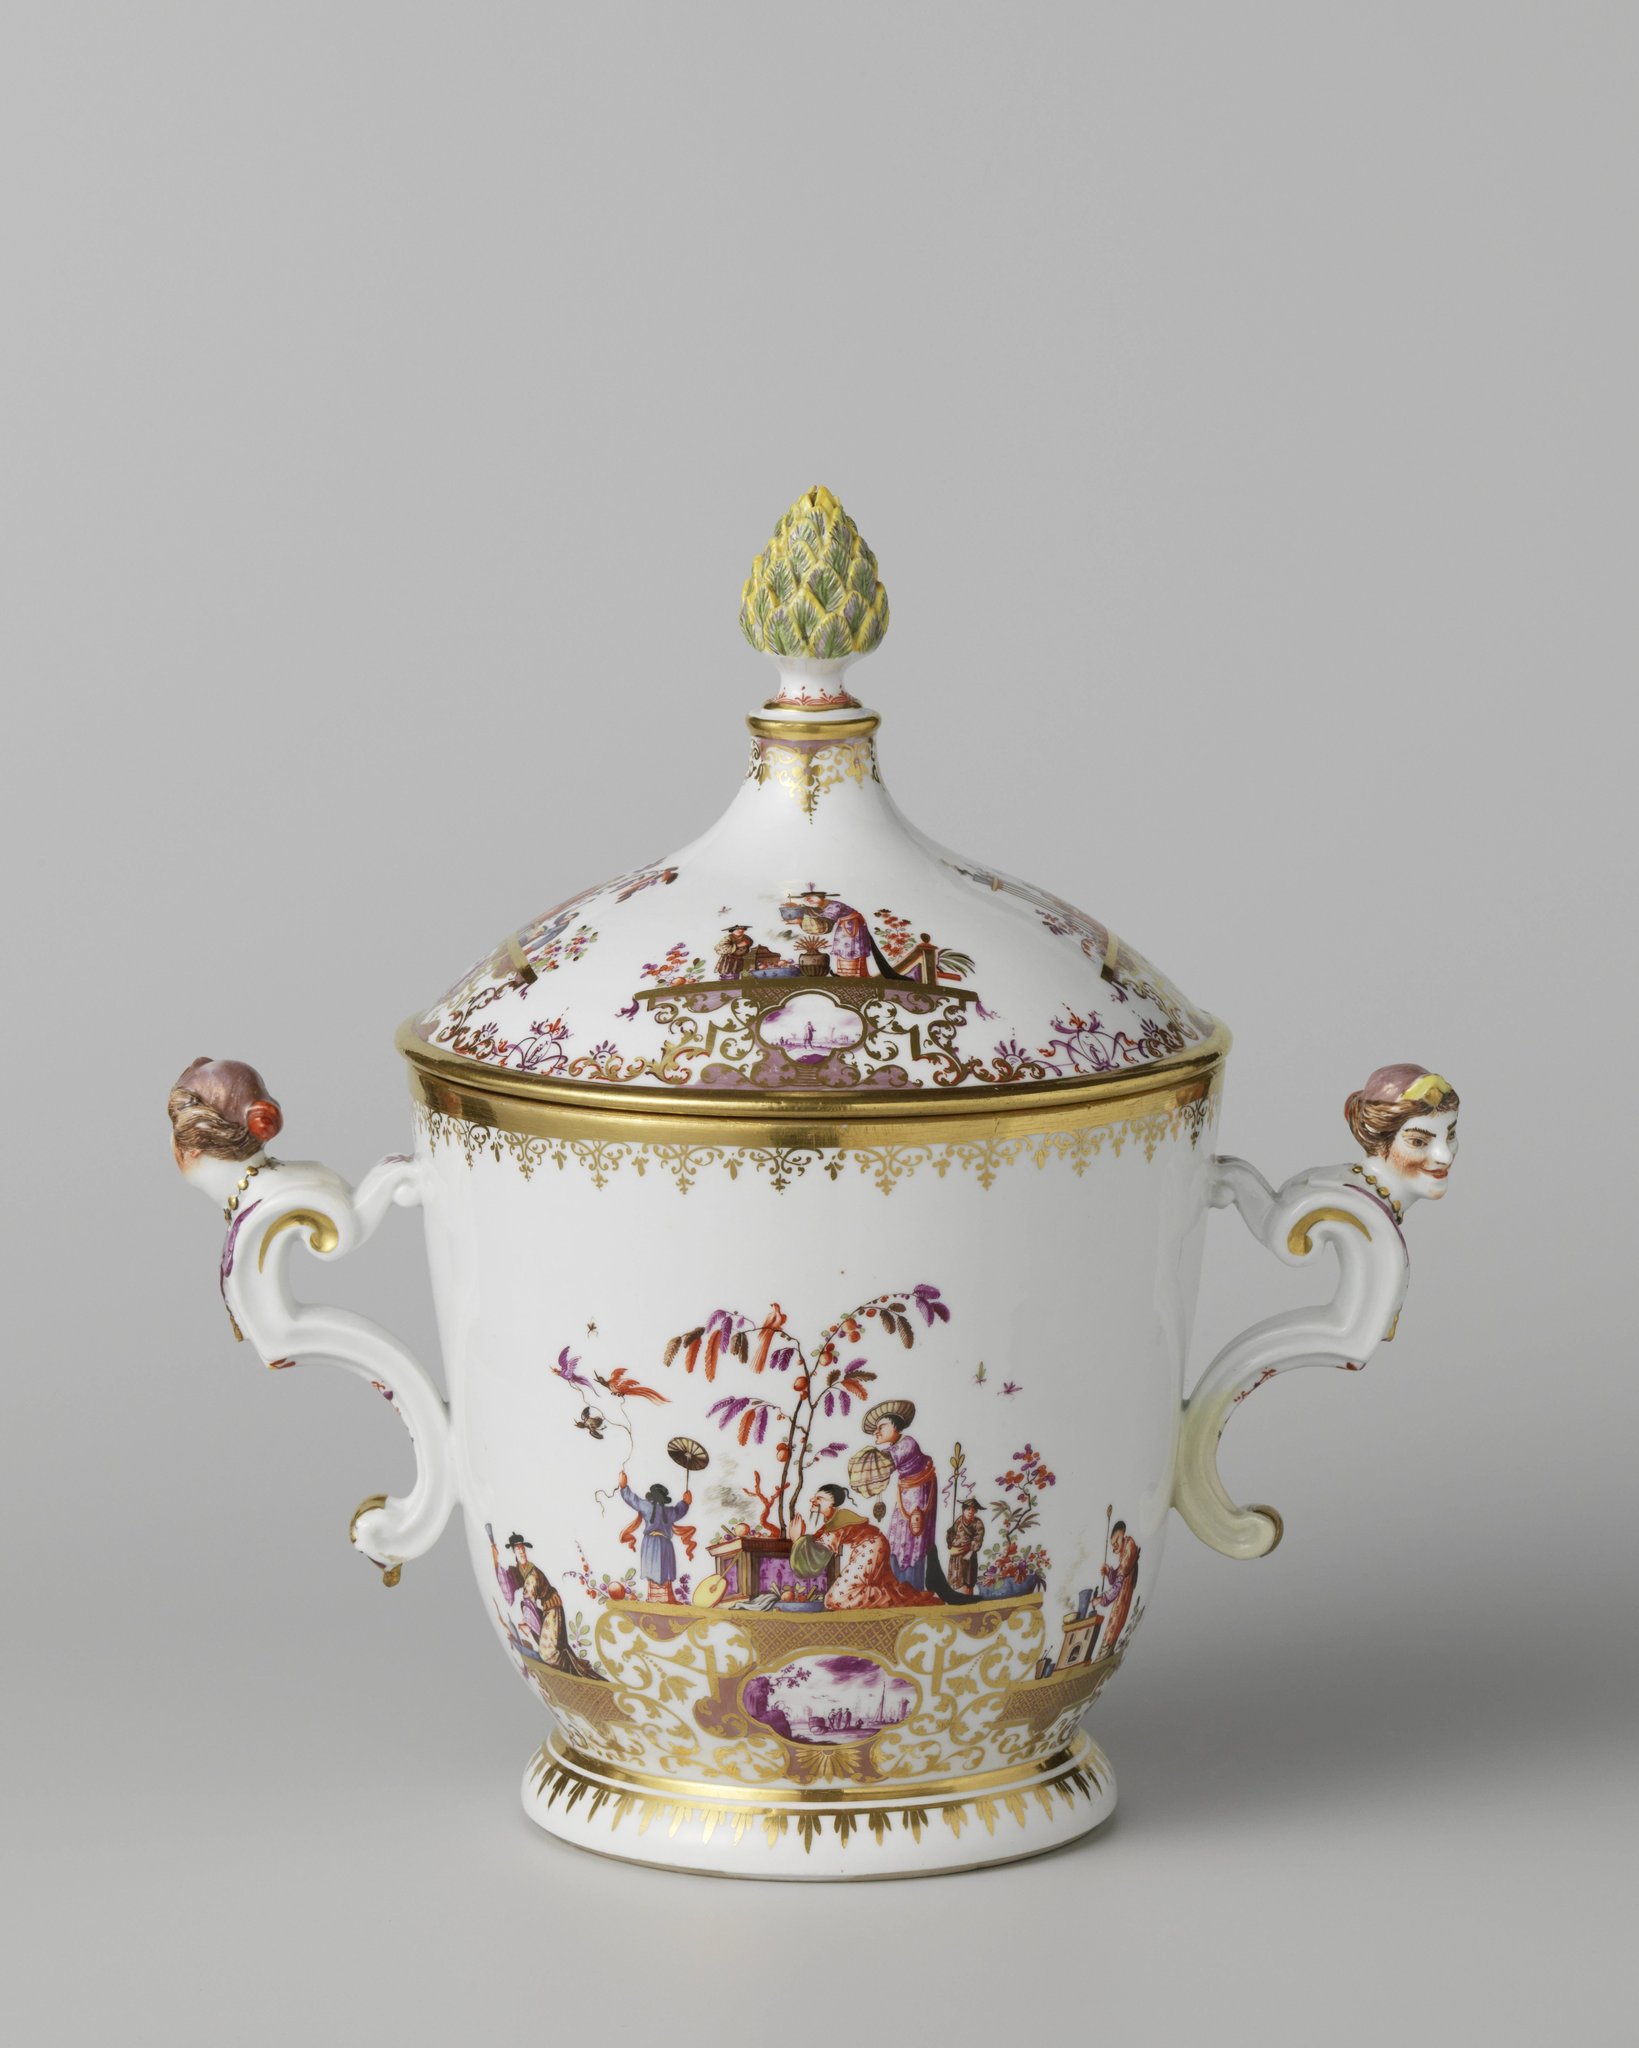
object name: eating drinking utensil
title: Deksel, veelkleurig beschilderd met chinoiserieën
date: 1730-1735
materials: porcelain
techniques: painted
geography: meissen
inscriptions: factory mark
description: Deksel van terrine met deksel van beschilderd porselein. Het deksel eindigt in een artisjok. Hett deksel is versierd met vier Höroldt-chinoiserieën op consoles bestaande uit band-, blad- en netwerk met palmetten in goud.